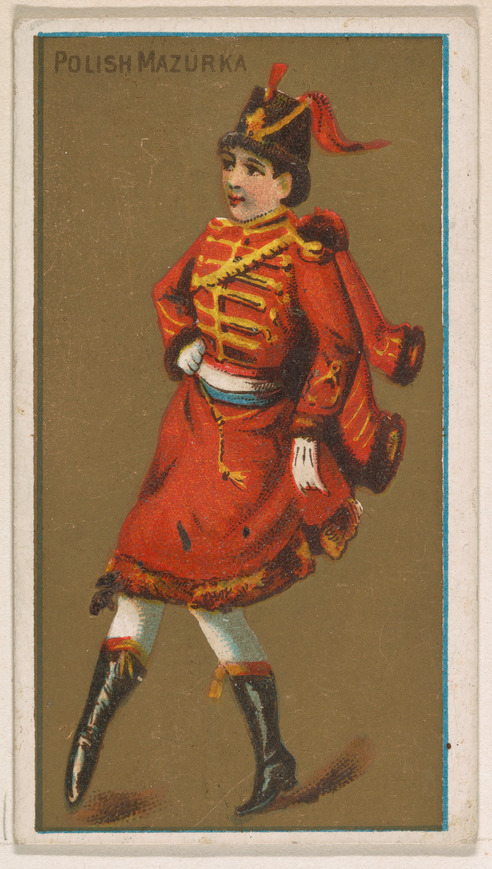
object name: print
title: Polish Mazurka, from National Dances (N225, Type 1) issued by Kinney Bros.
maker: kinney brothers tobacco company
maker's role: publisher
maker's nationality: american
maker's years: 1869-2011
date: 1889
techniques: color lithograph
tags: women,dancing,dancers